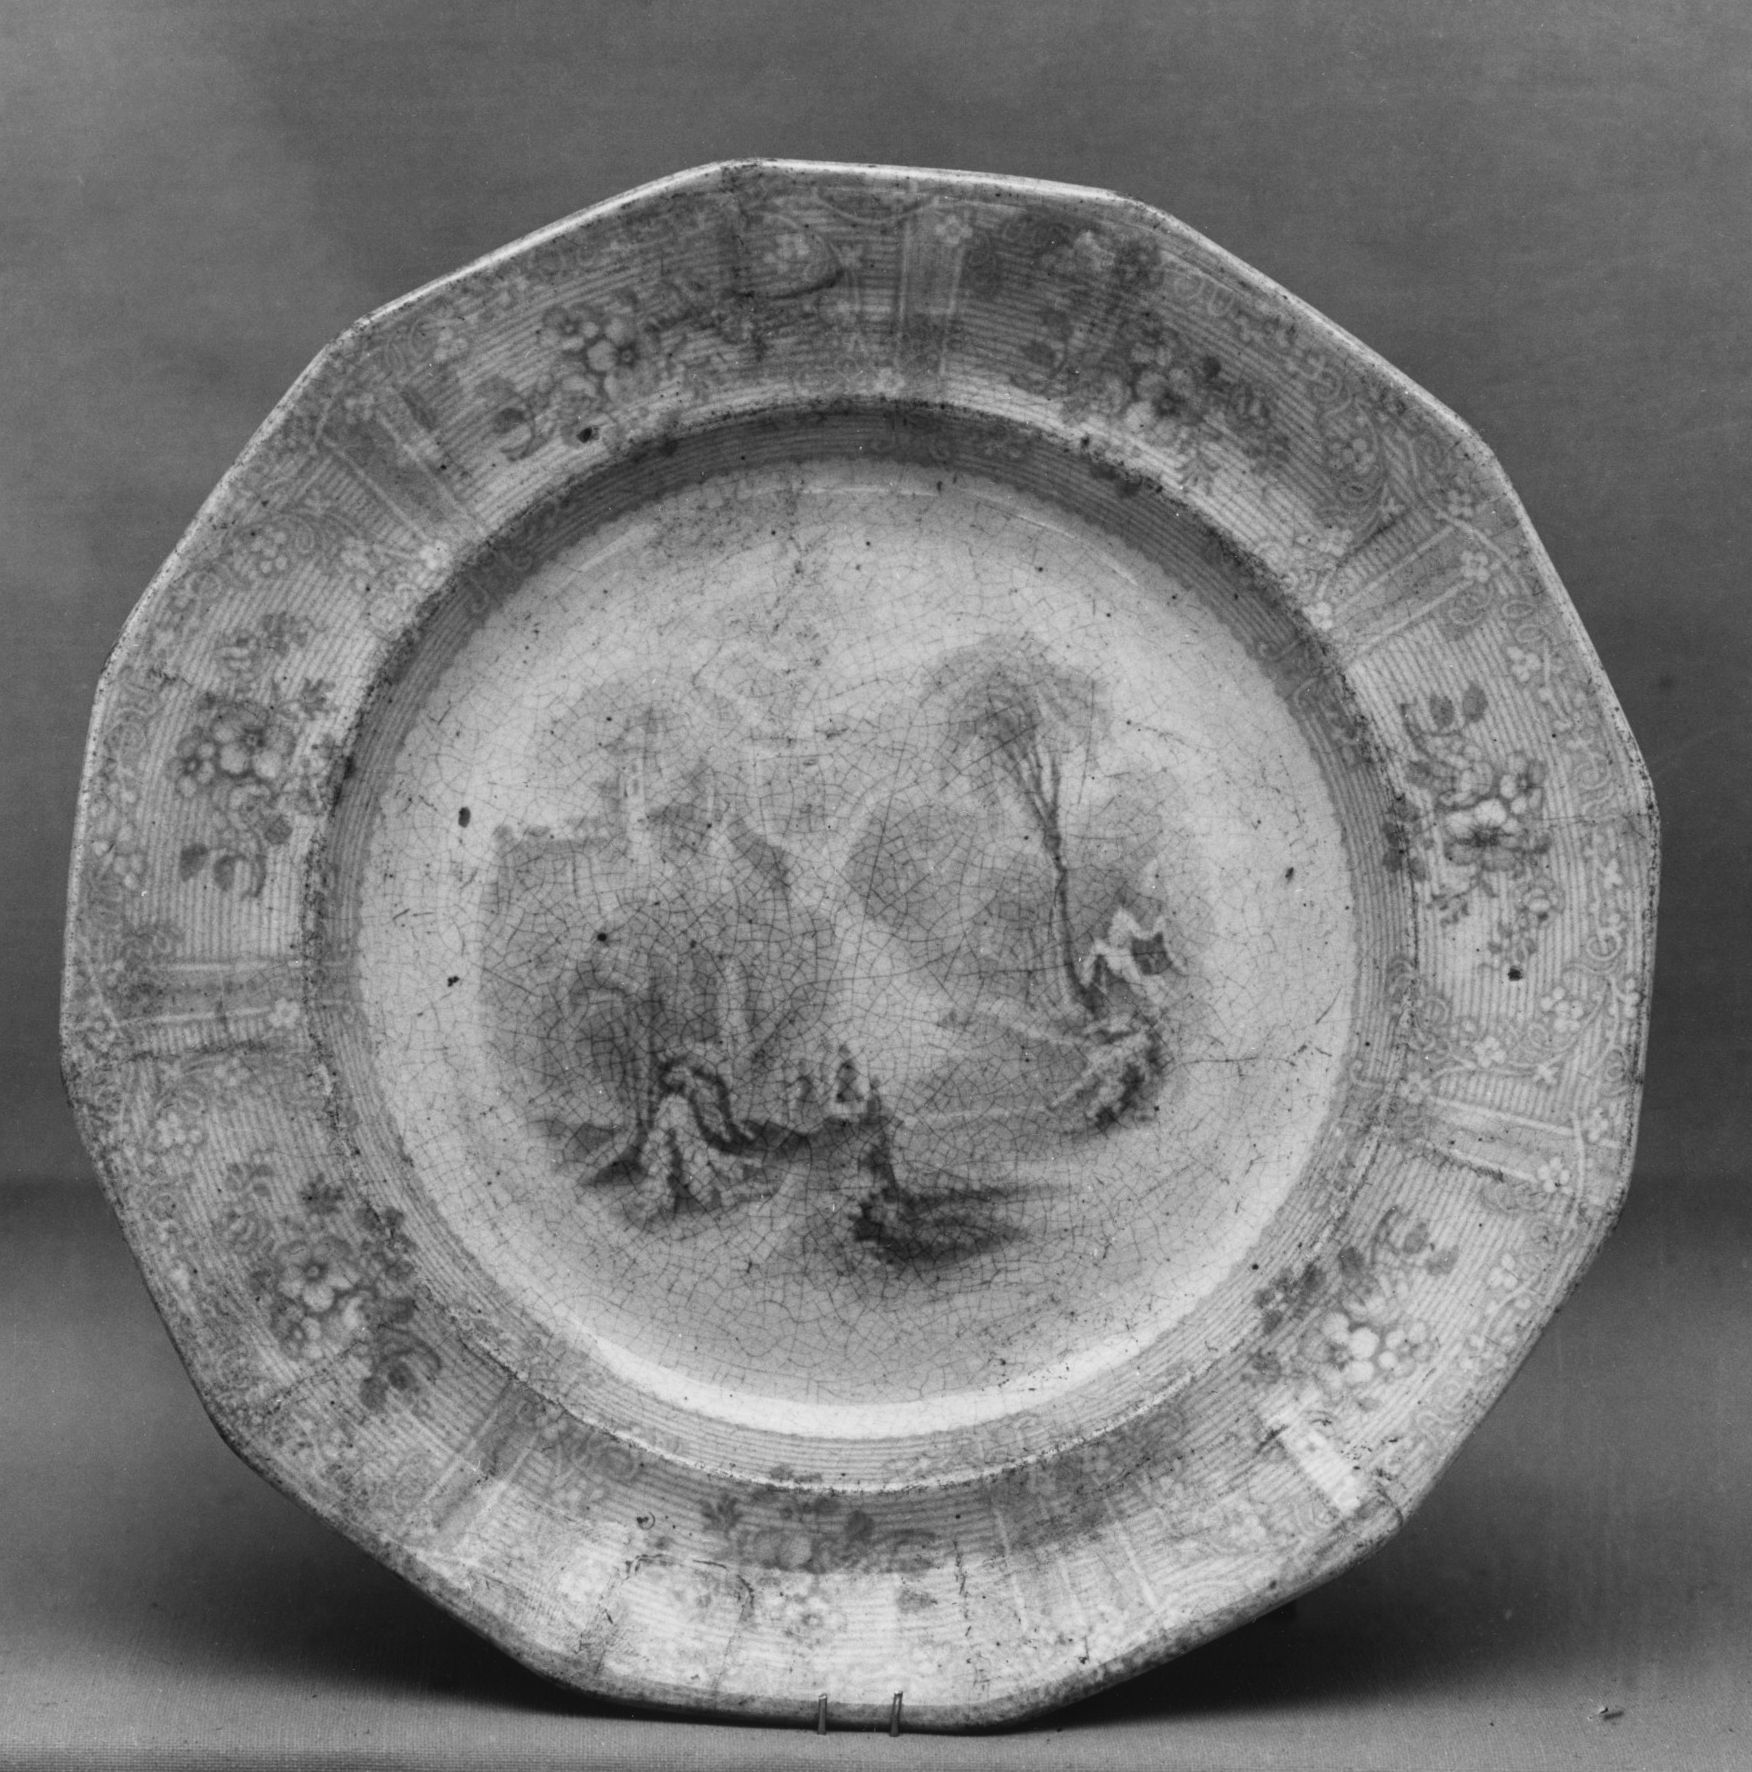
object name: dish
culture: british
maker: joseph heath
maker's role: maker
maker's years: 1842-1853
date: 1845-1853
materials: earthenware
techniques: transfer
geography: england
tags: landscapes